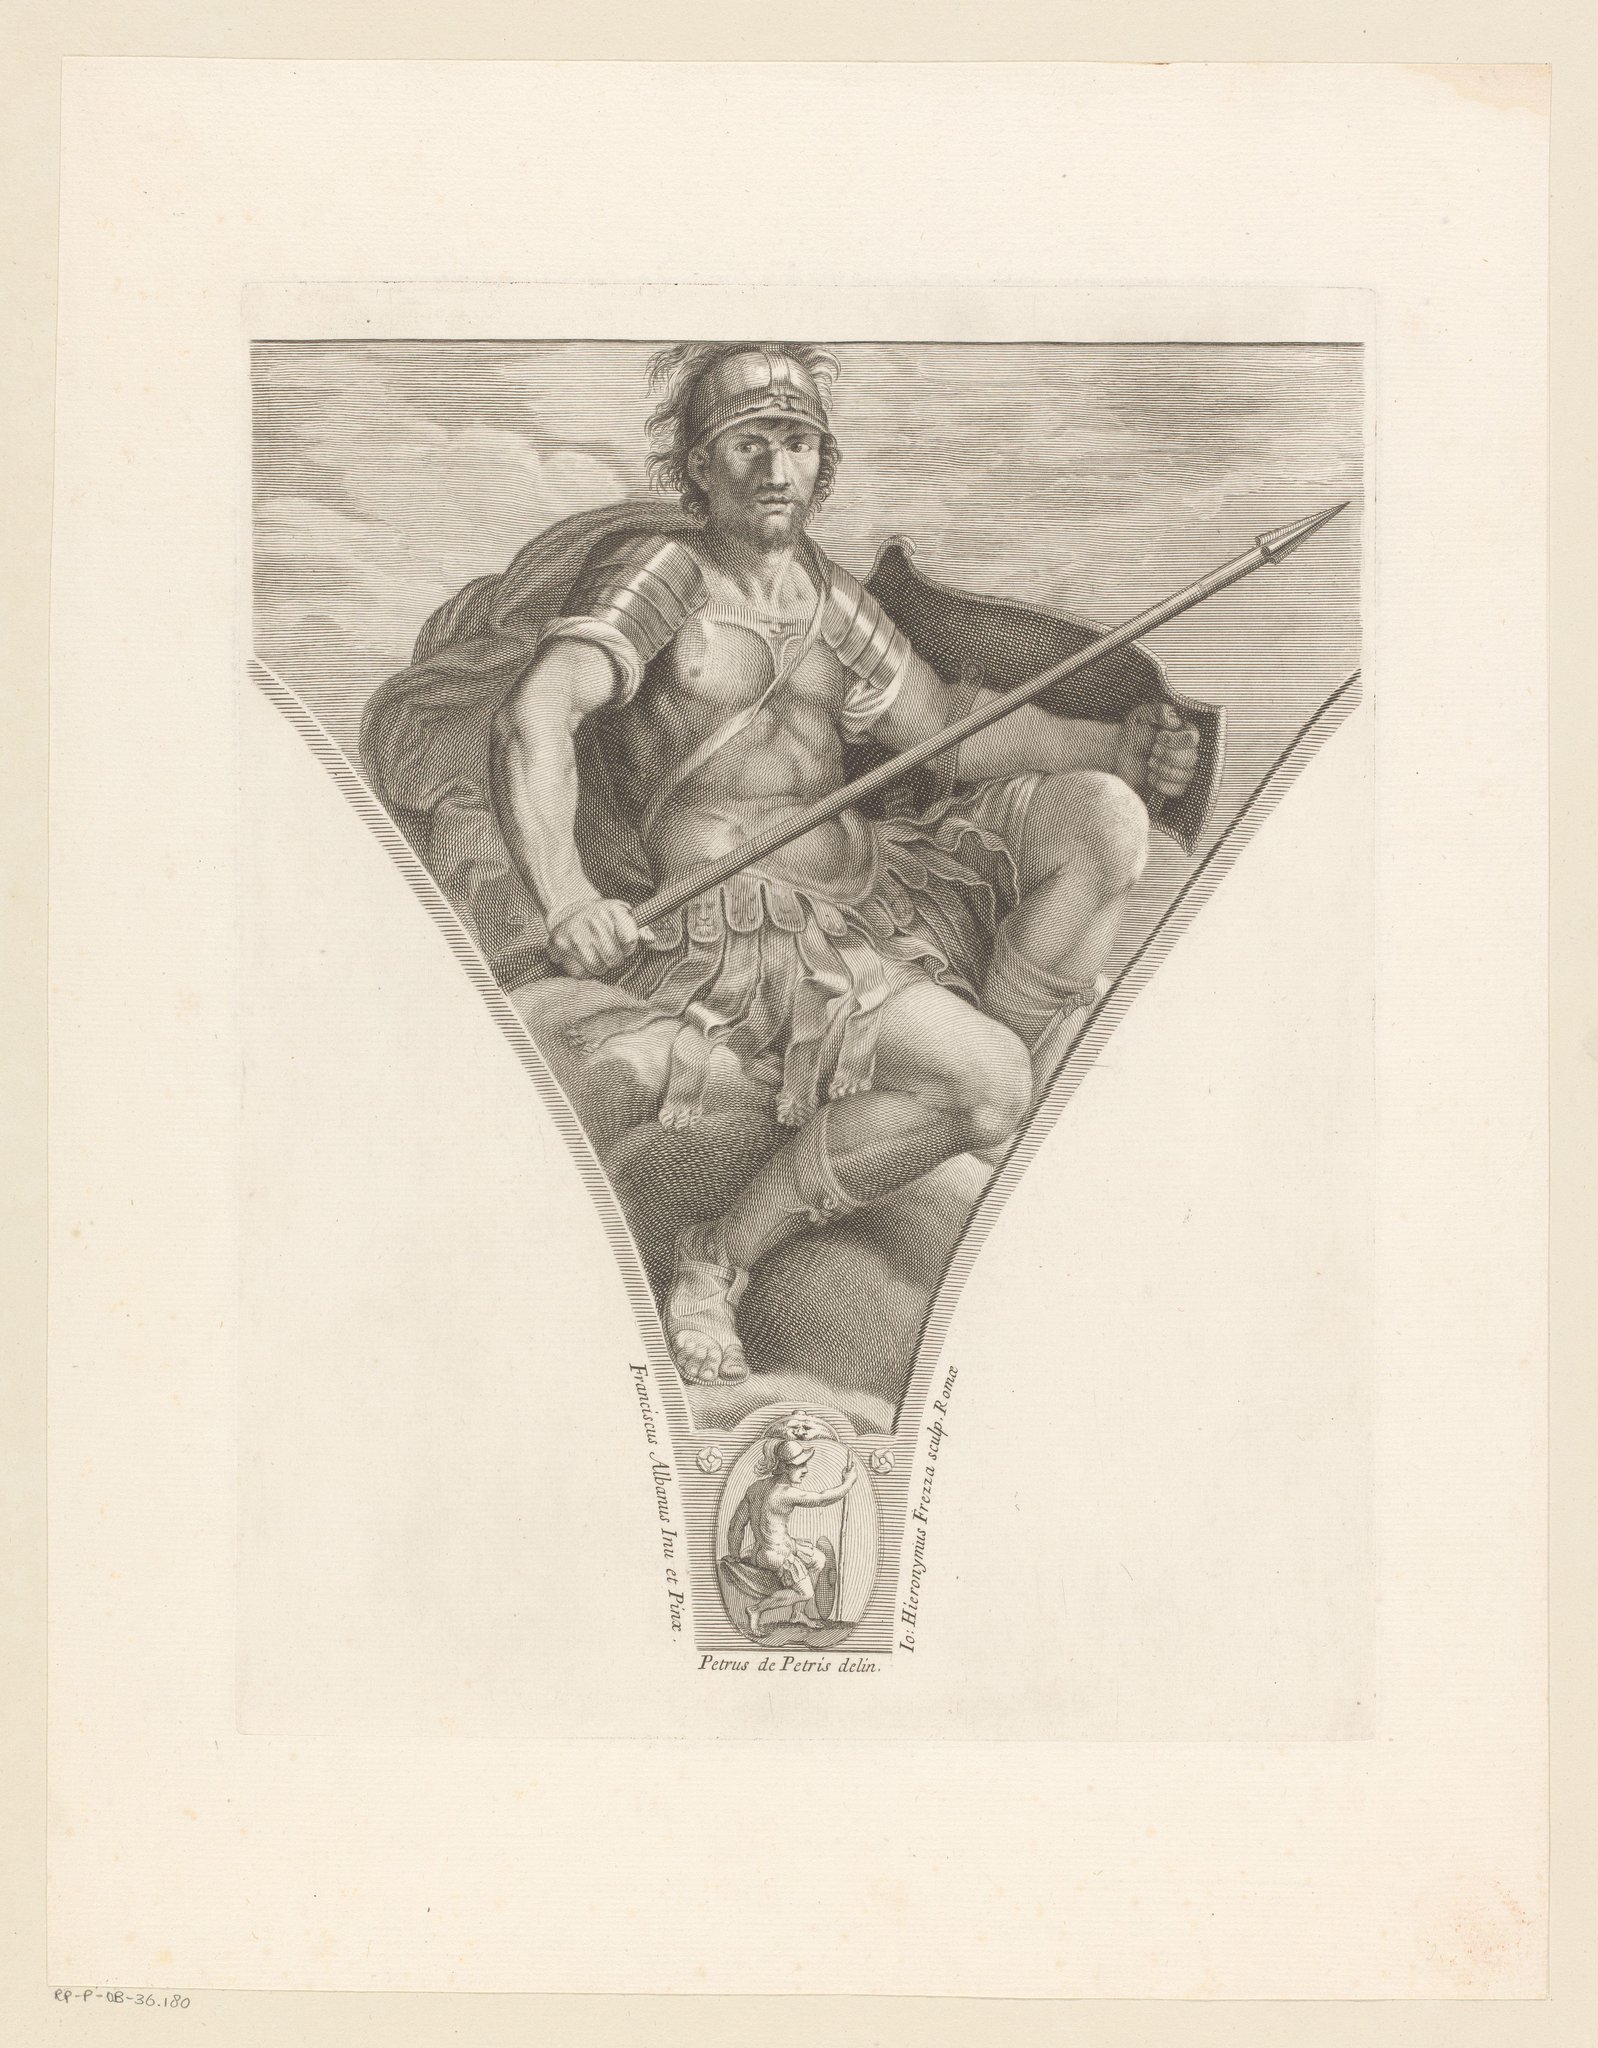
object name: print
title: Schilderingen door Francesco Albani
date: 1704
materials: paper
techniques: engraving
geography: italy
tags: (story of) mars (ares)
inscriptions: collector's mark: Lugt 240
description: Prent uit een reeks van prenten naar ontwerpen door Francesco Albani.